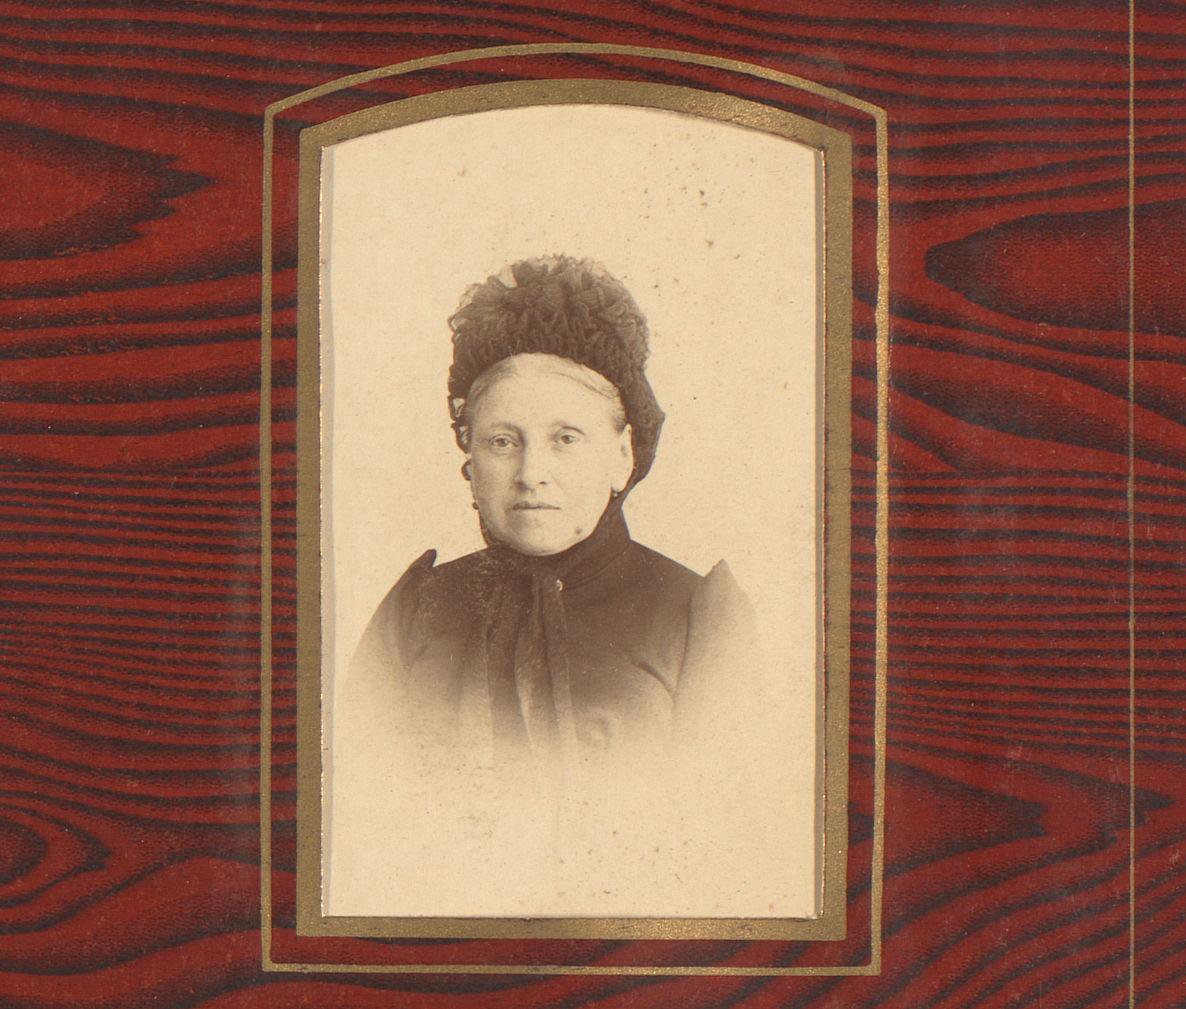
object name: carte de visite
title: Portret van een vrouw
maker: Anonymous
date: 1880-1930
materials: cardboard, photographic support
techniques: albumen print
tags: adult woman, historical persons